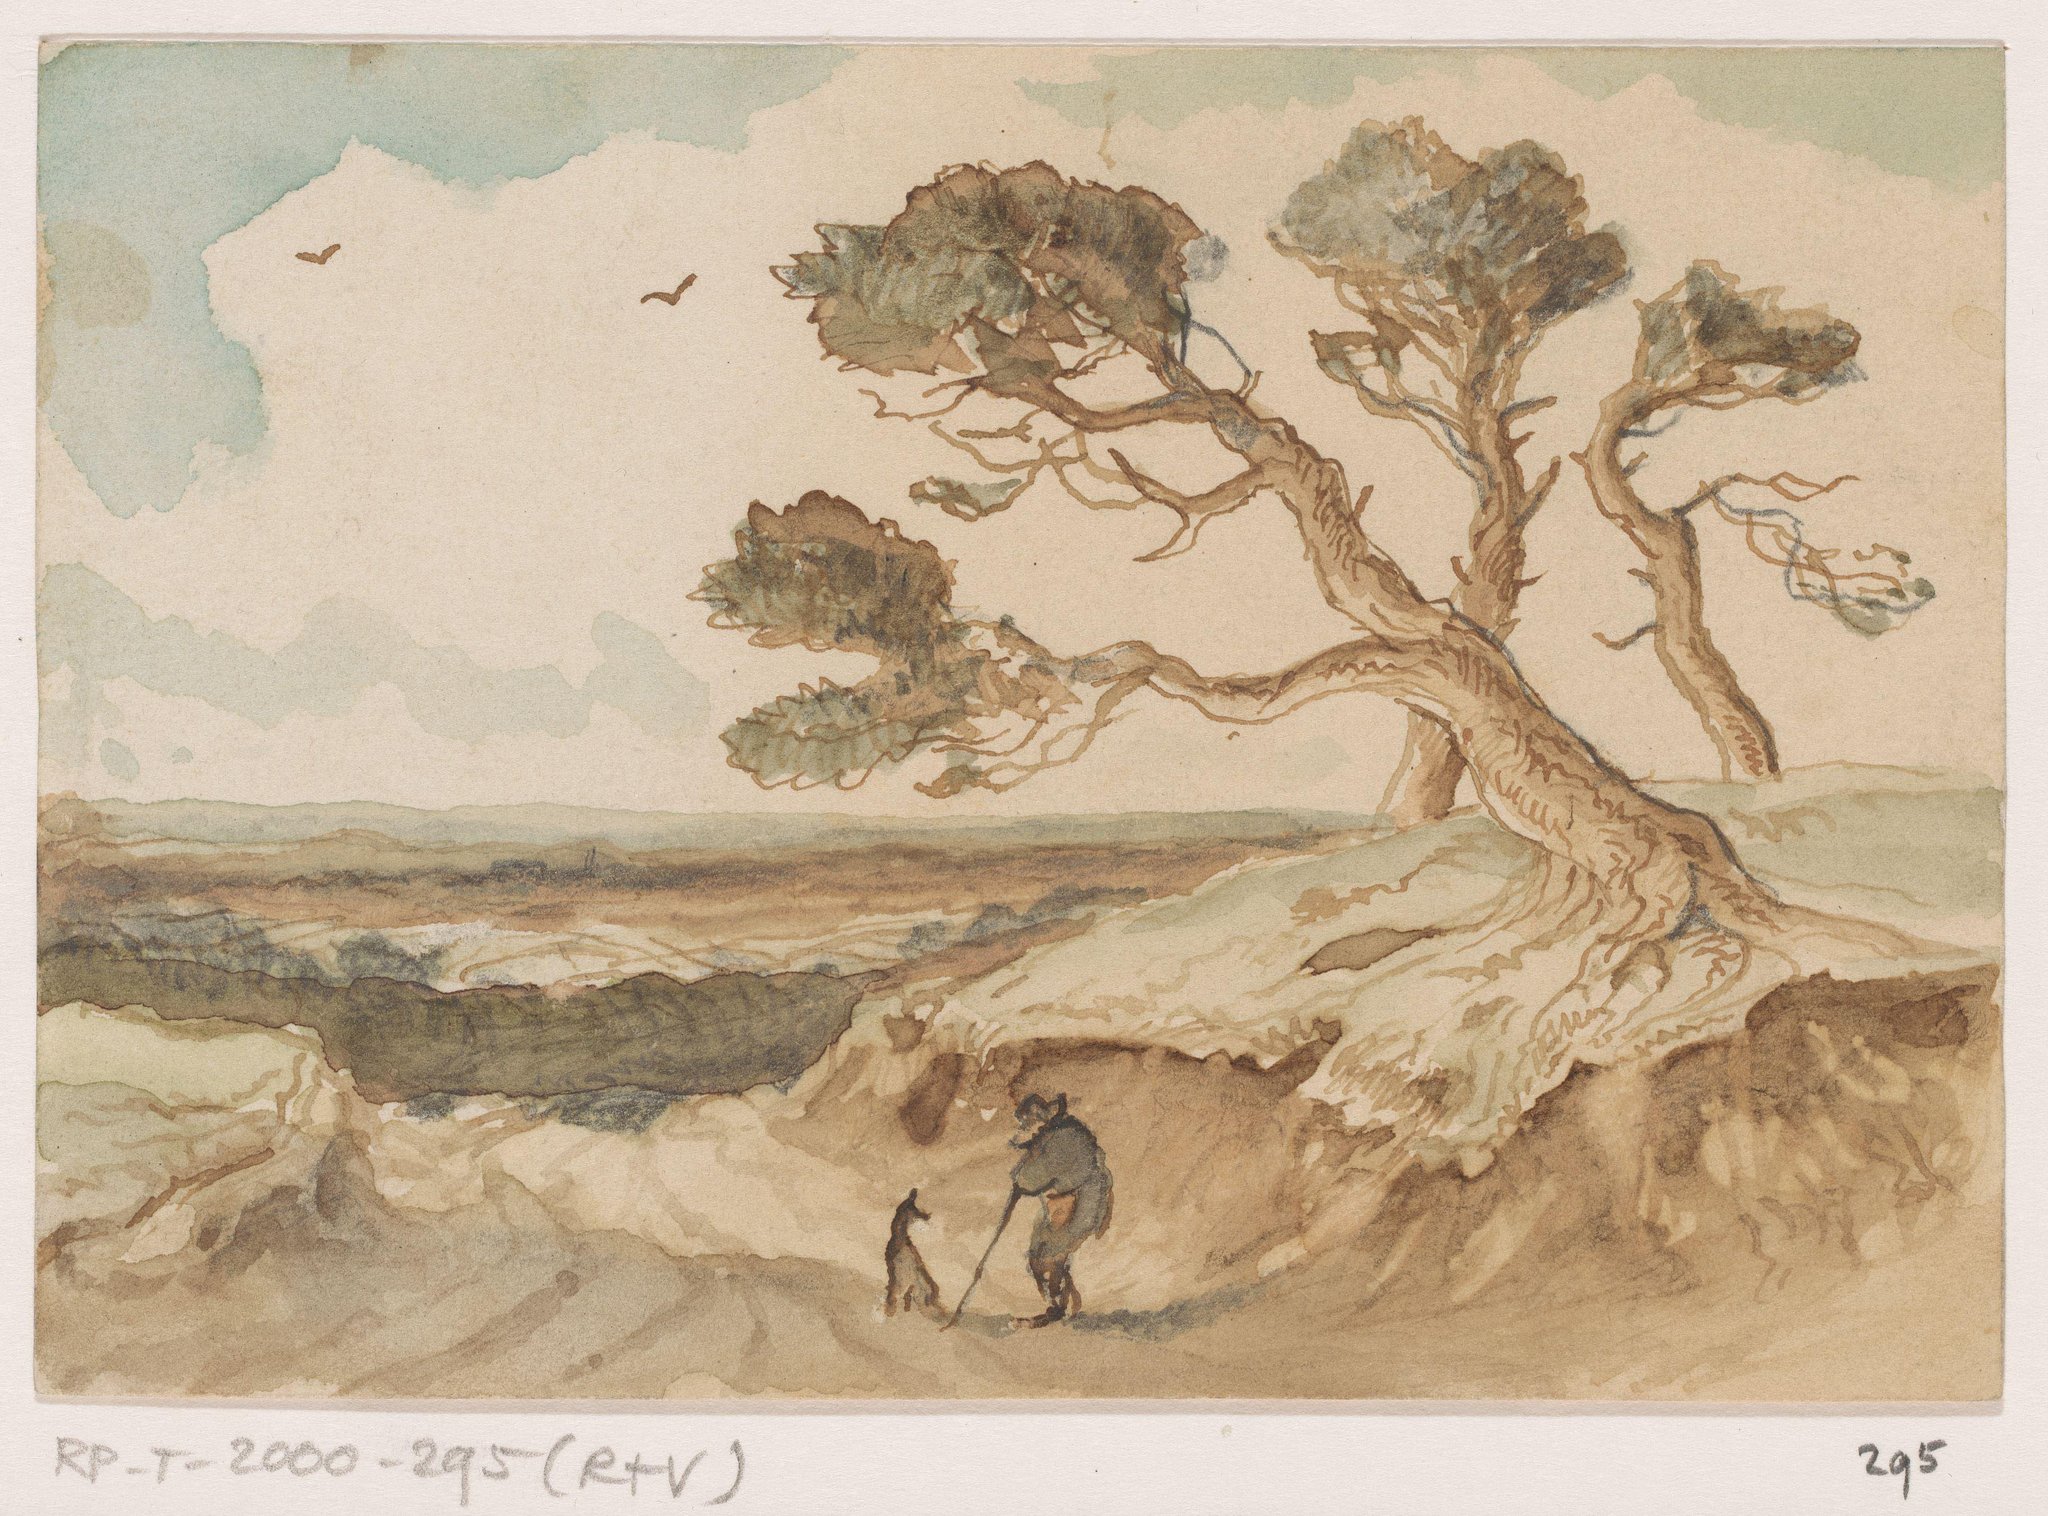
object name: drawing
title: Heidelandschap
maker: johannes tavenraat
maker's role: draughtsman, painter, print maker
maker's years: 1809-1881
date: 1880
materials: ink, paper, watercolor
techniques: brush, pen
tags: low hill country (+ landscape with figures, staffage)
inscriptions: date